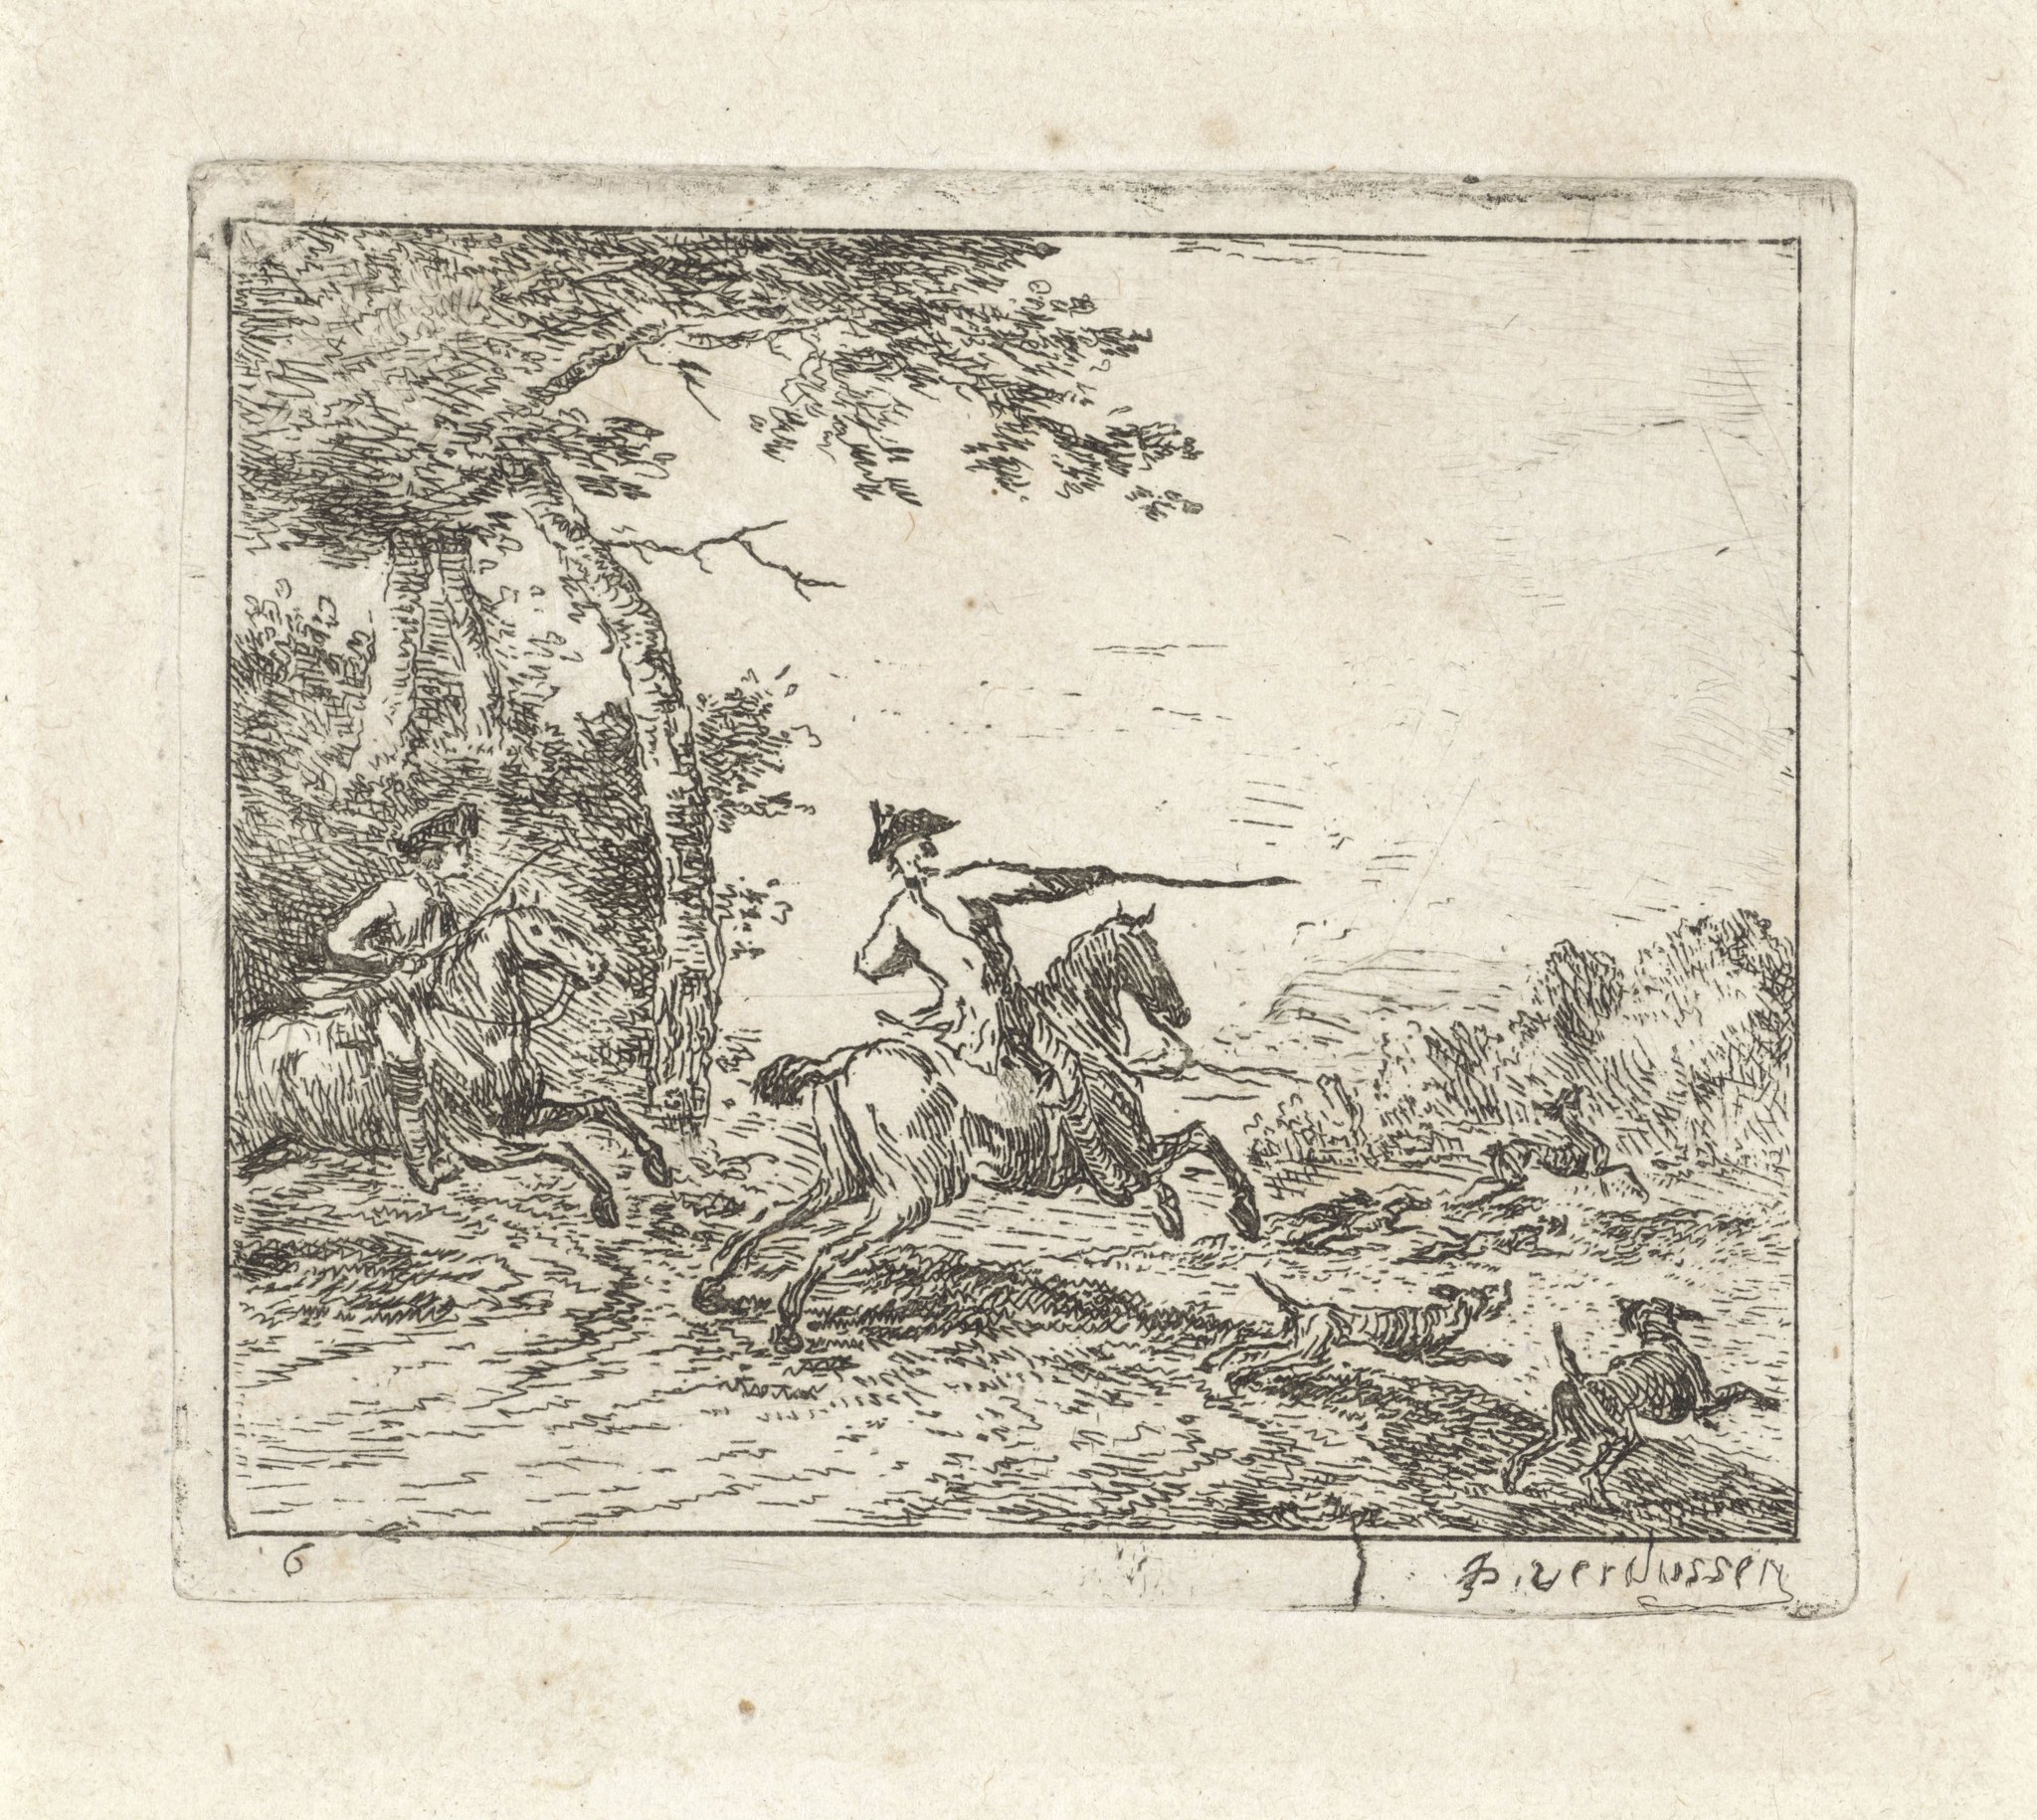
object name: print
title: Hertenjacht met twee ruiters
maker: jan peeter verdussen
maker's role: print maker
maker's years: 1700-1763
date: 1710-1763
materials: paper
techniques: etching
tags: riding a horse, ass, or mule; rider, horseman, stag-hunting, hunting dogs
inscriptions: collector's mark: Lugt 2760, collector's mark: Lugt 2228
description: Twee ruiters tijdens een hertenjacht in een landschap. Op de voorgrond twee honden.